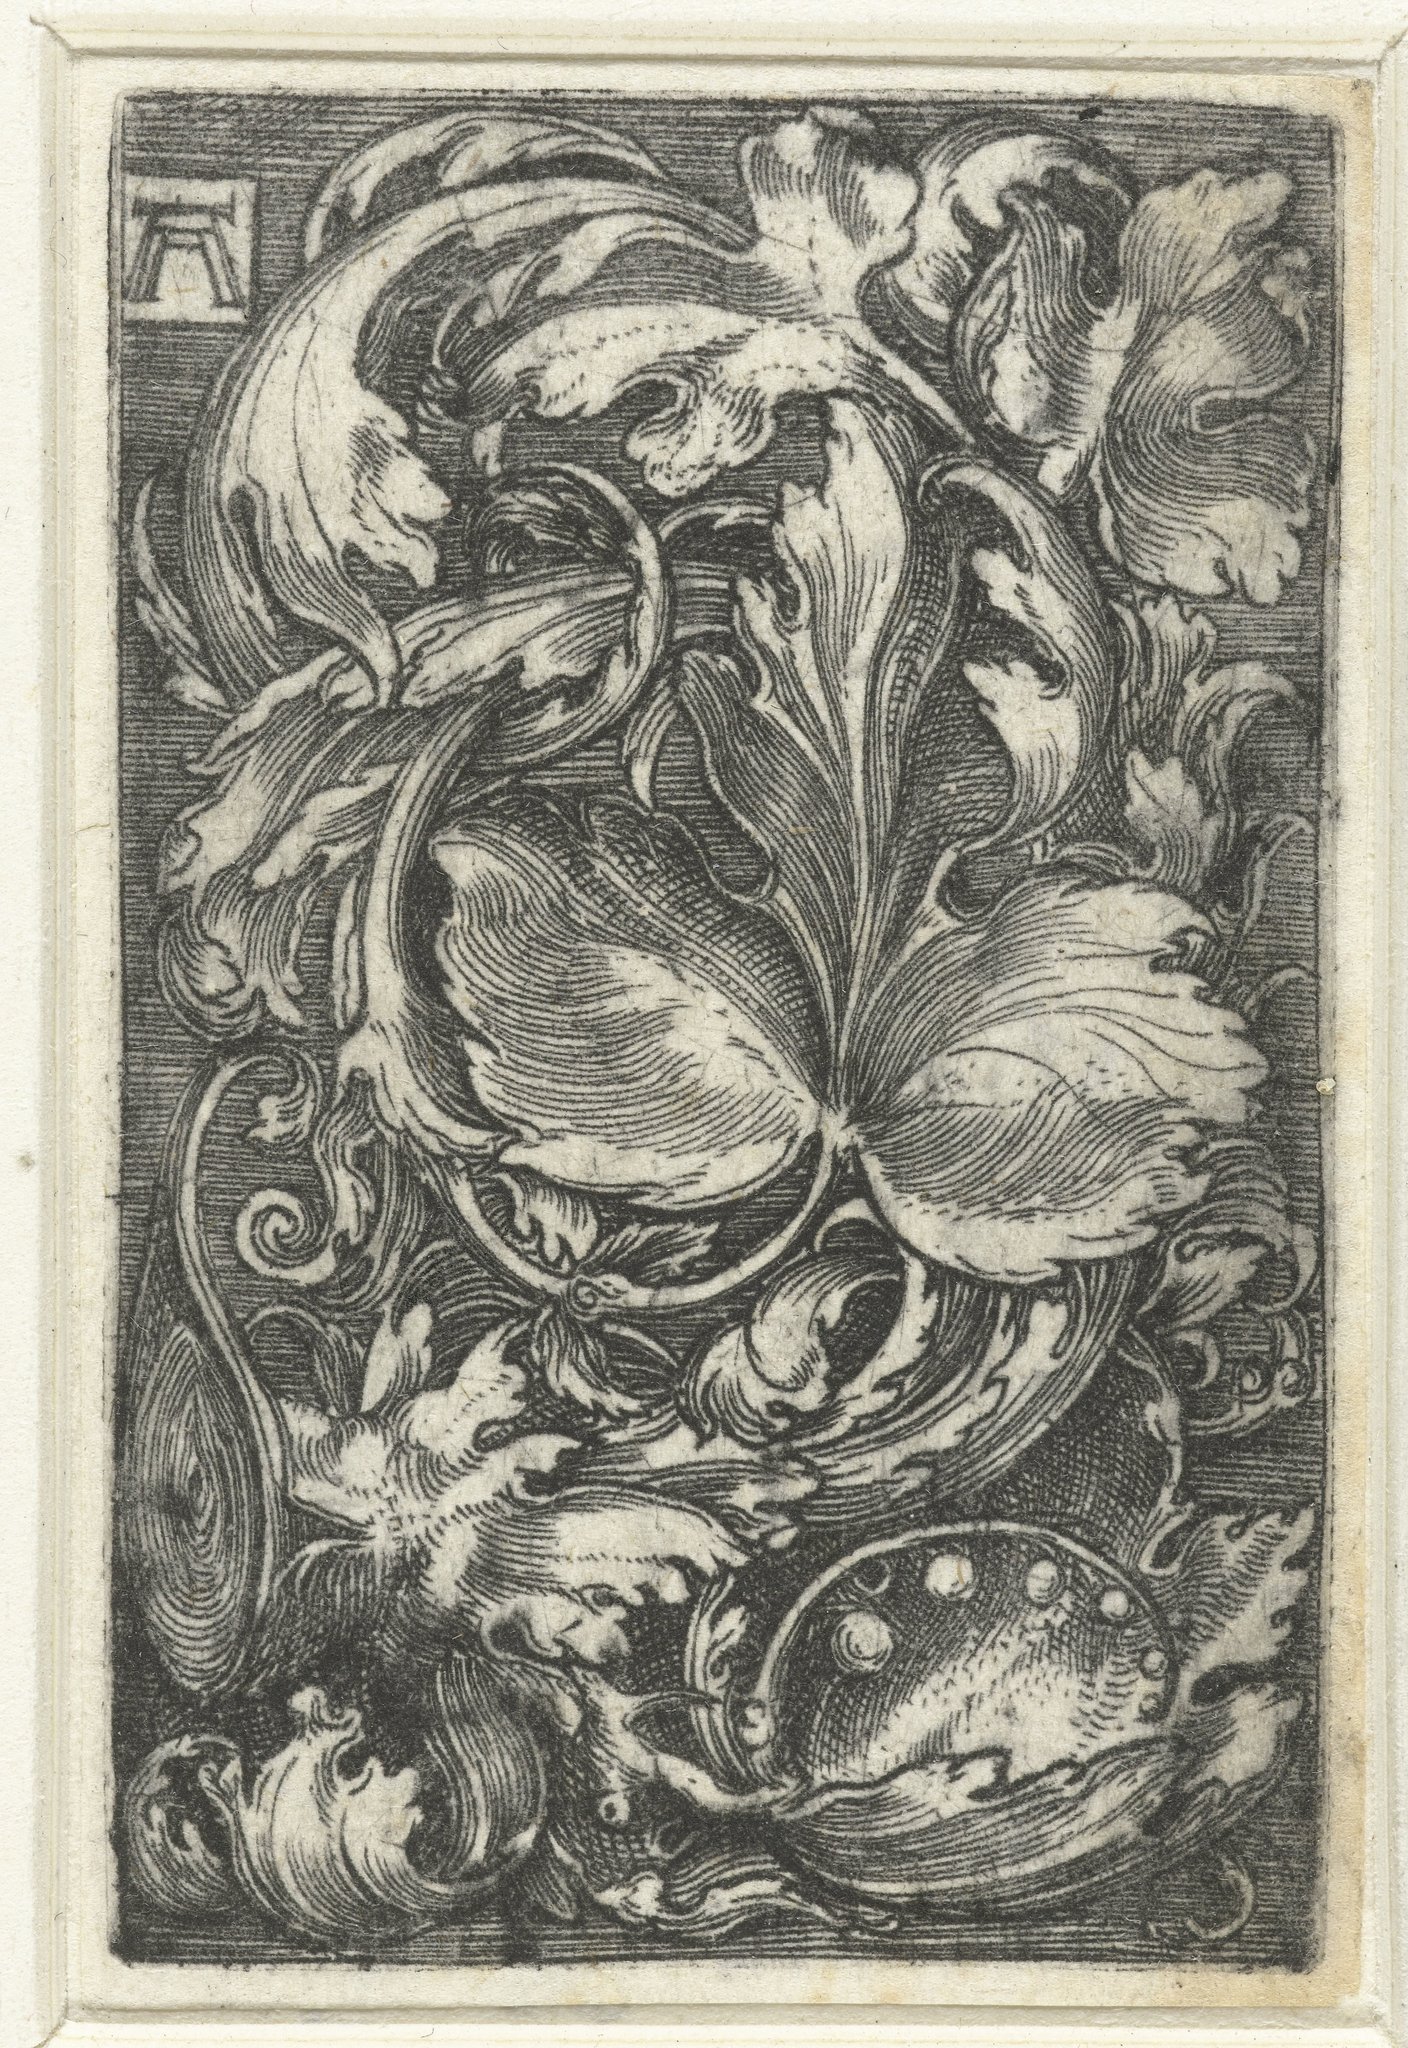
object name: print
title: Ornament met bladranken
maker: albrecht altdorfer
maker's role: draughtsman, print maker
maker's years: 1480-1538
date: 1506-1538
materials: paper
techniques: engraving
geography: germany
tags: ornament derived from plant forms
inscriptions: number: ‘12’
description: Vlakdecoratie met bladranken, rechtsonder een takje met bessen.